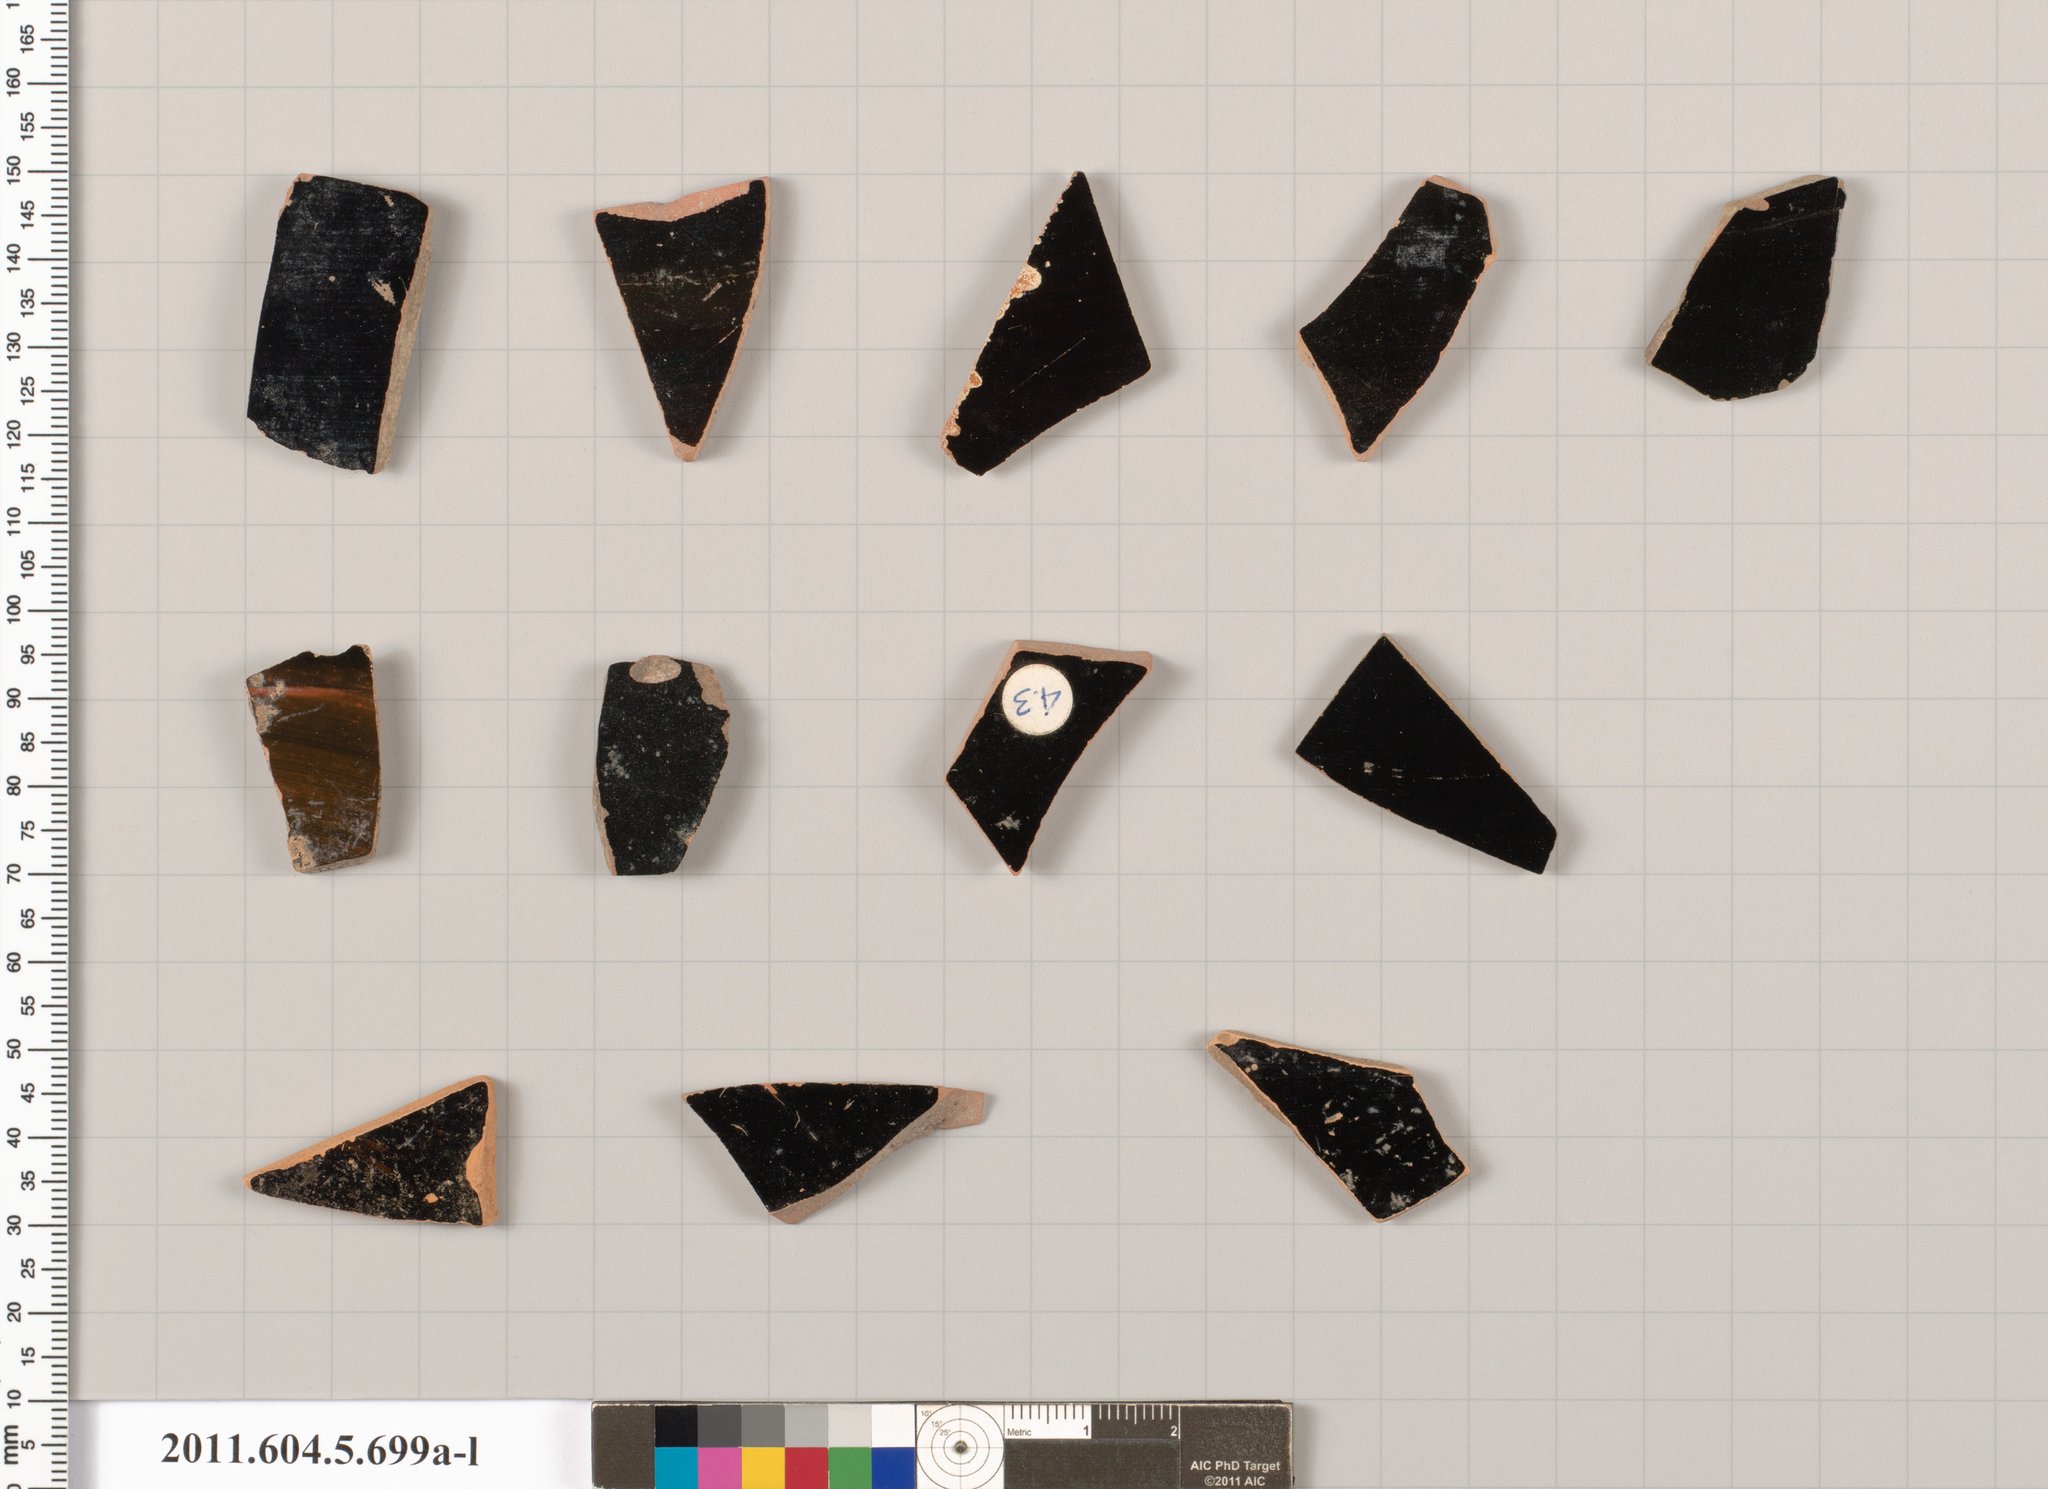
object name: kylix fragment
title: Terracotta fragments of kylikes (drinking cups)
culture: greek, attic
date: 600-401 BCE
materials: terracotta